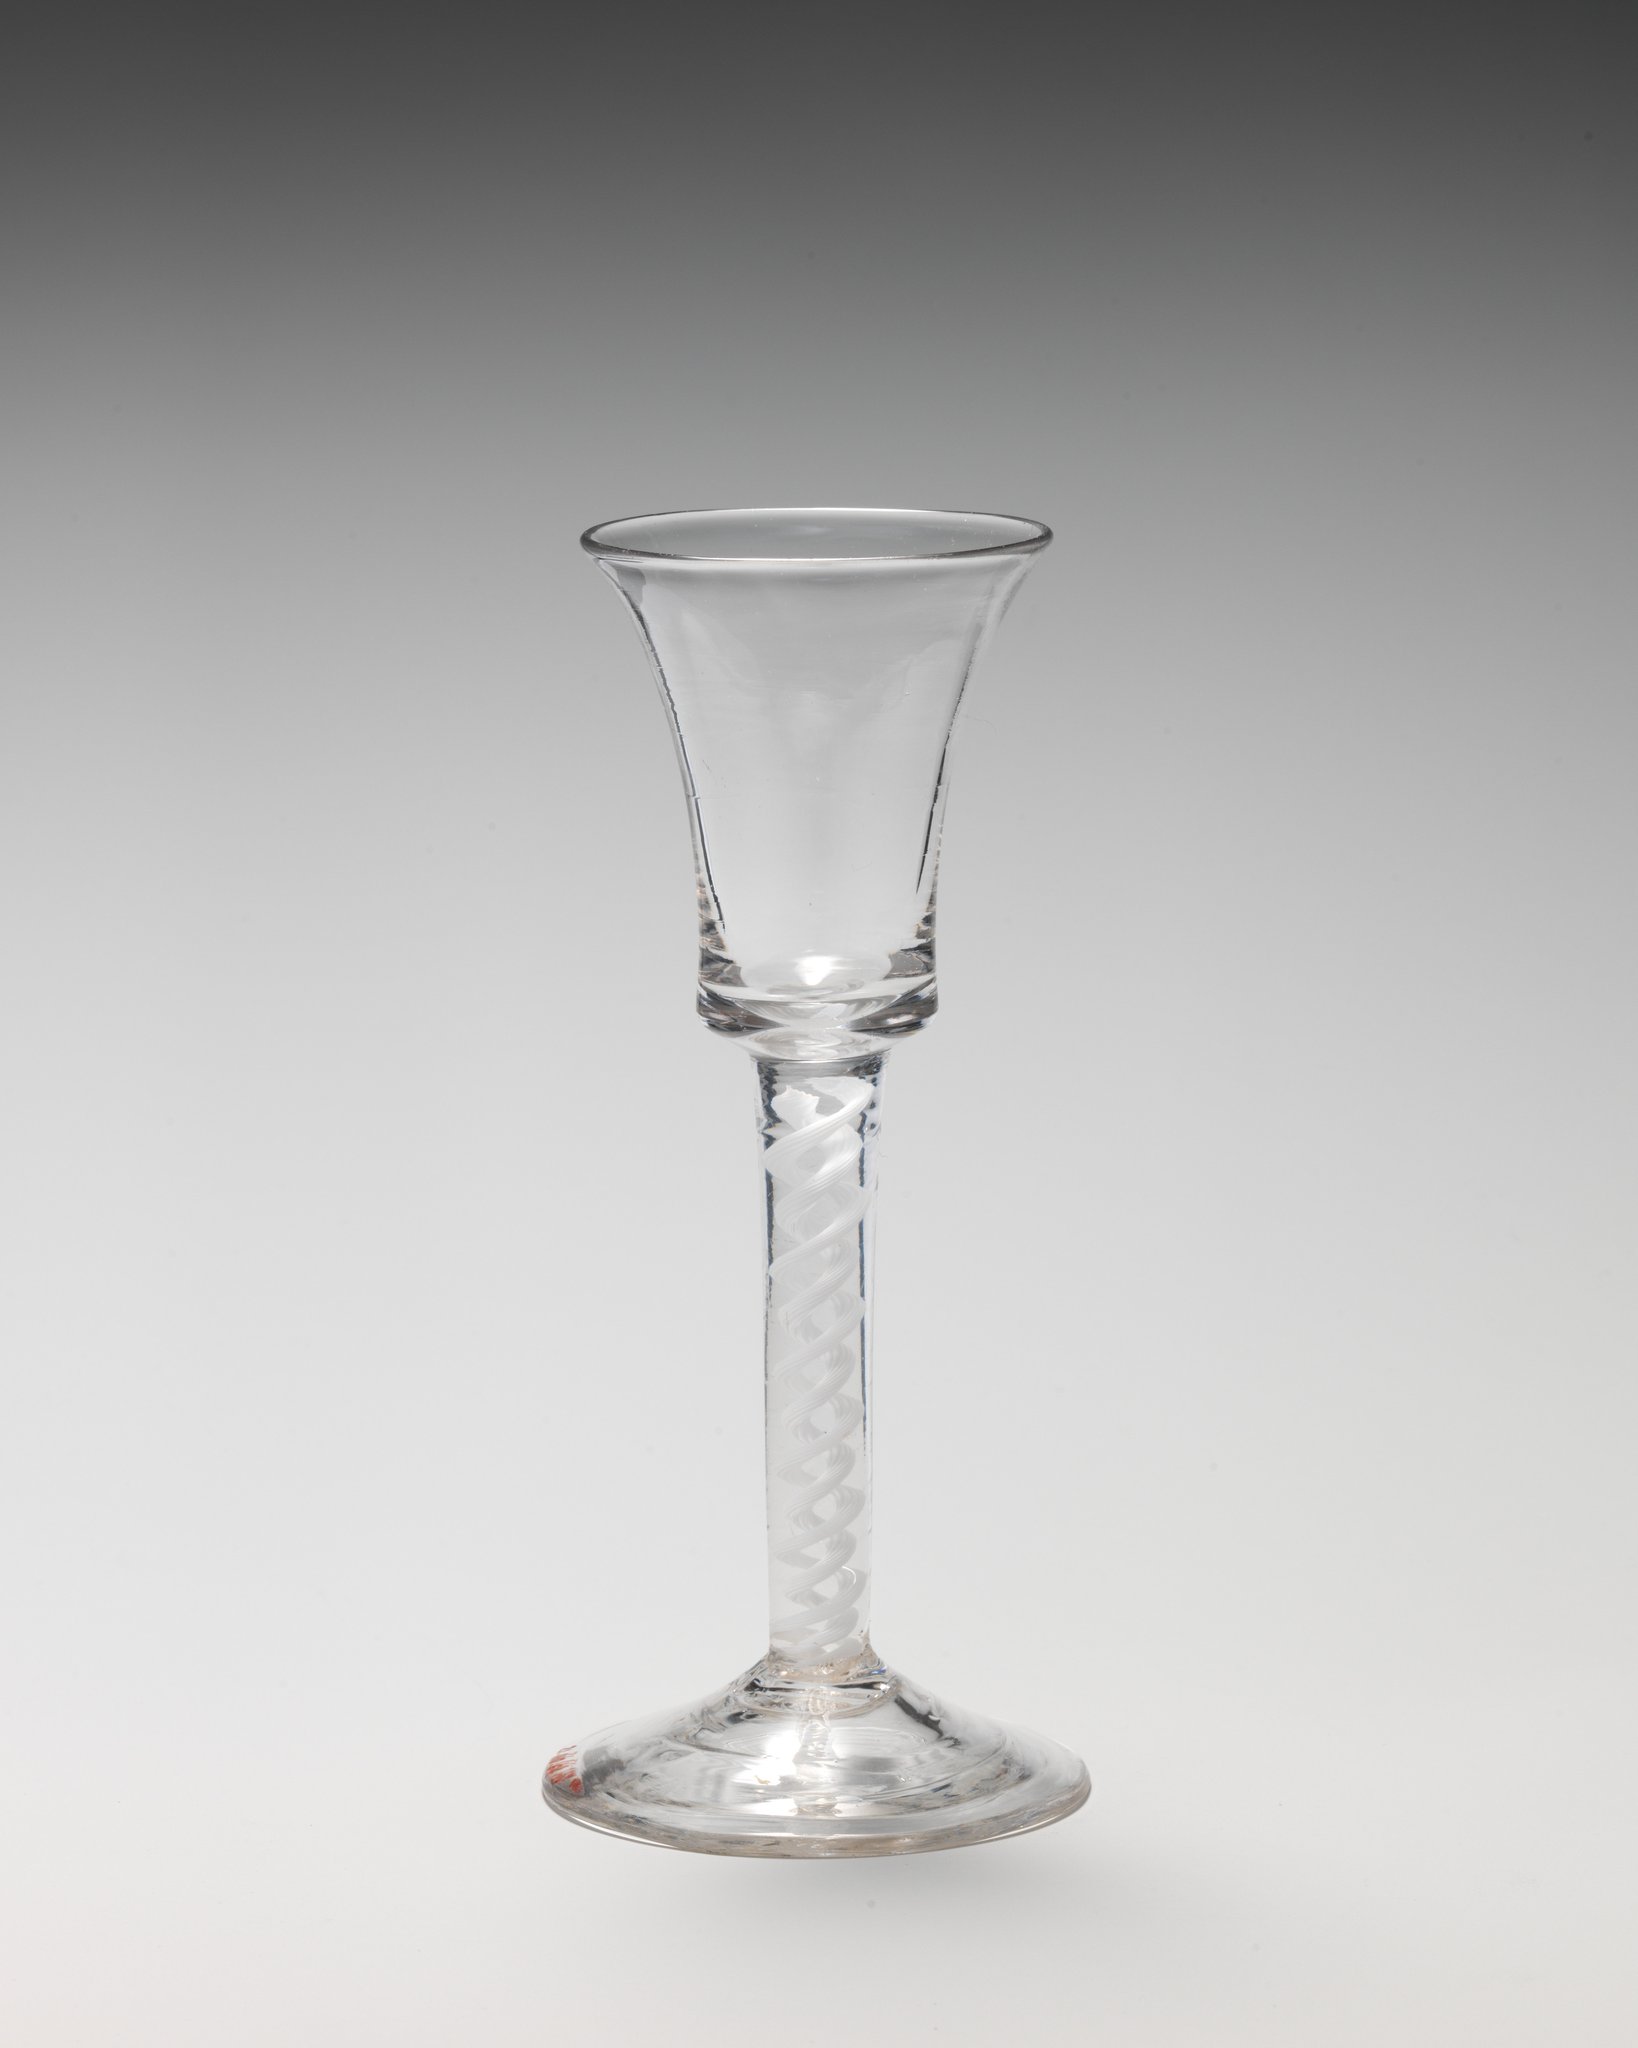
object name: wineglass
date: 1750-1800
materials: glass